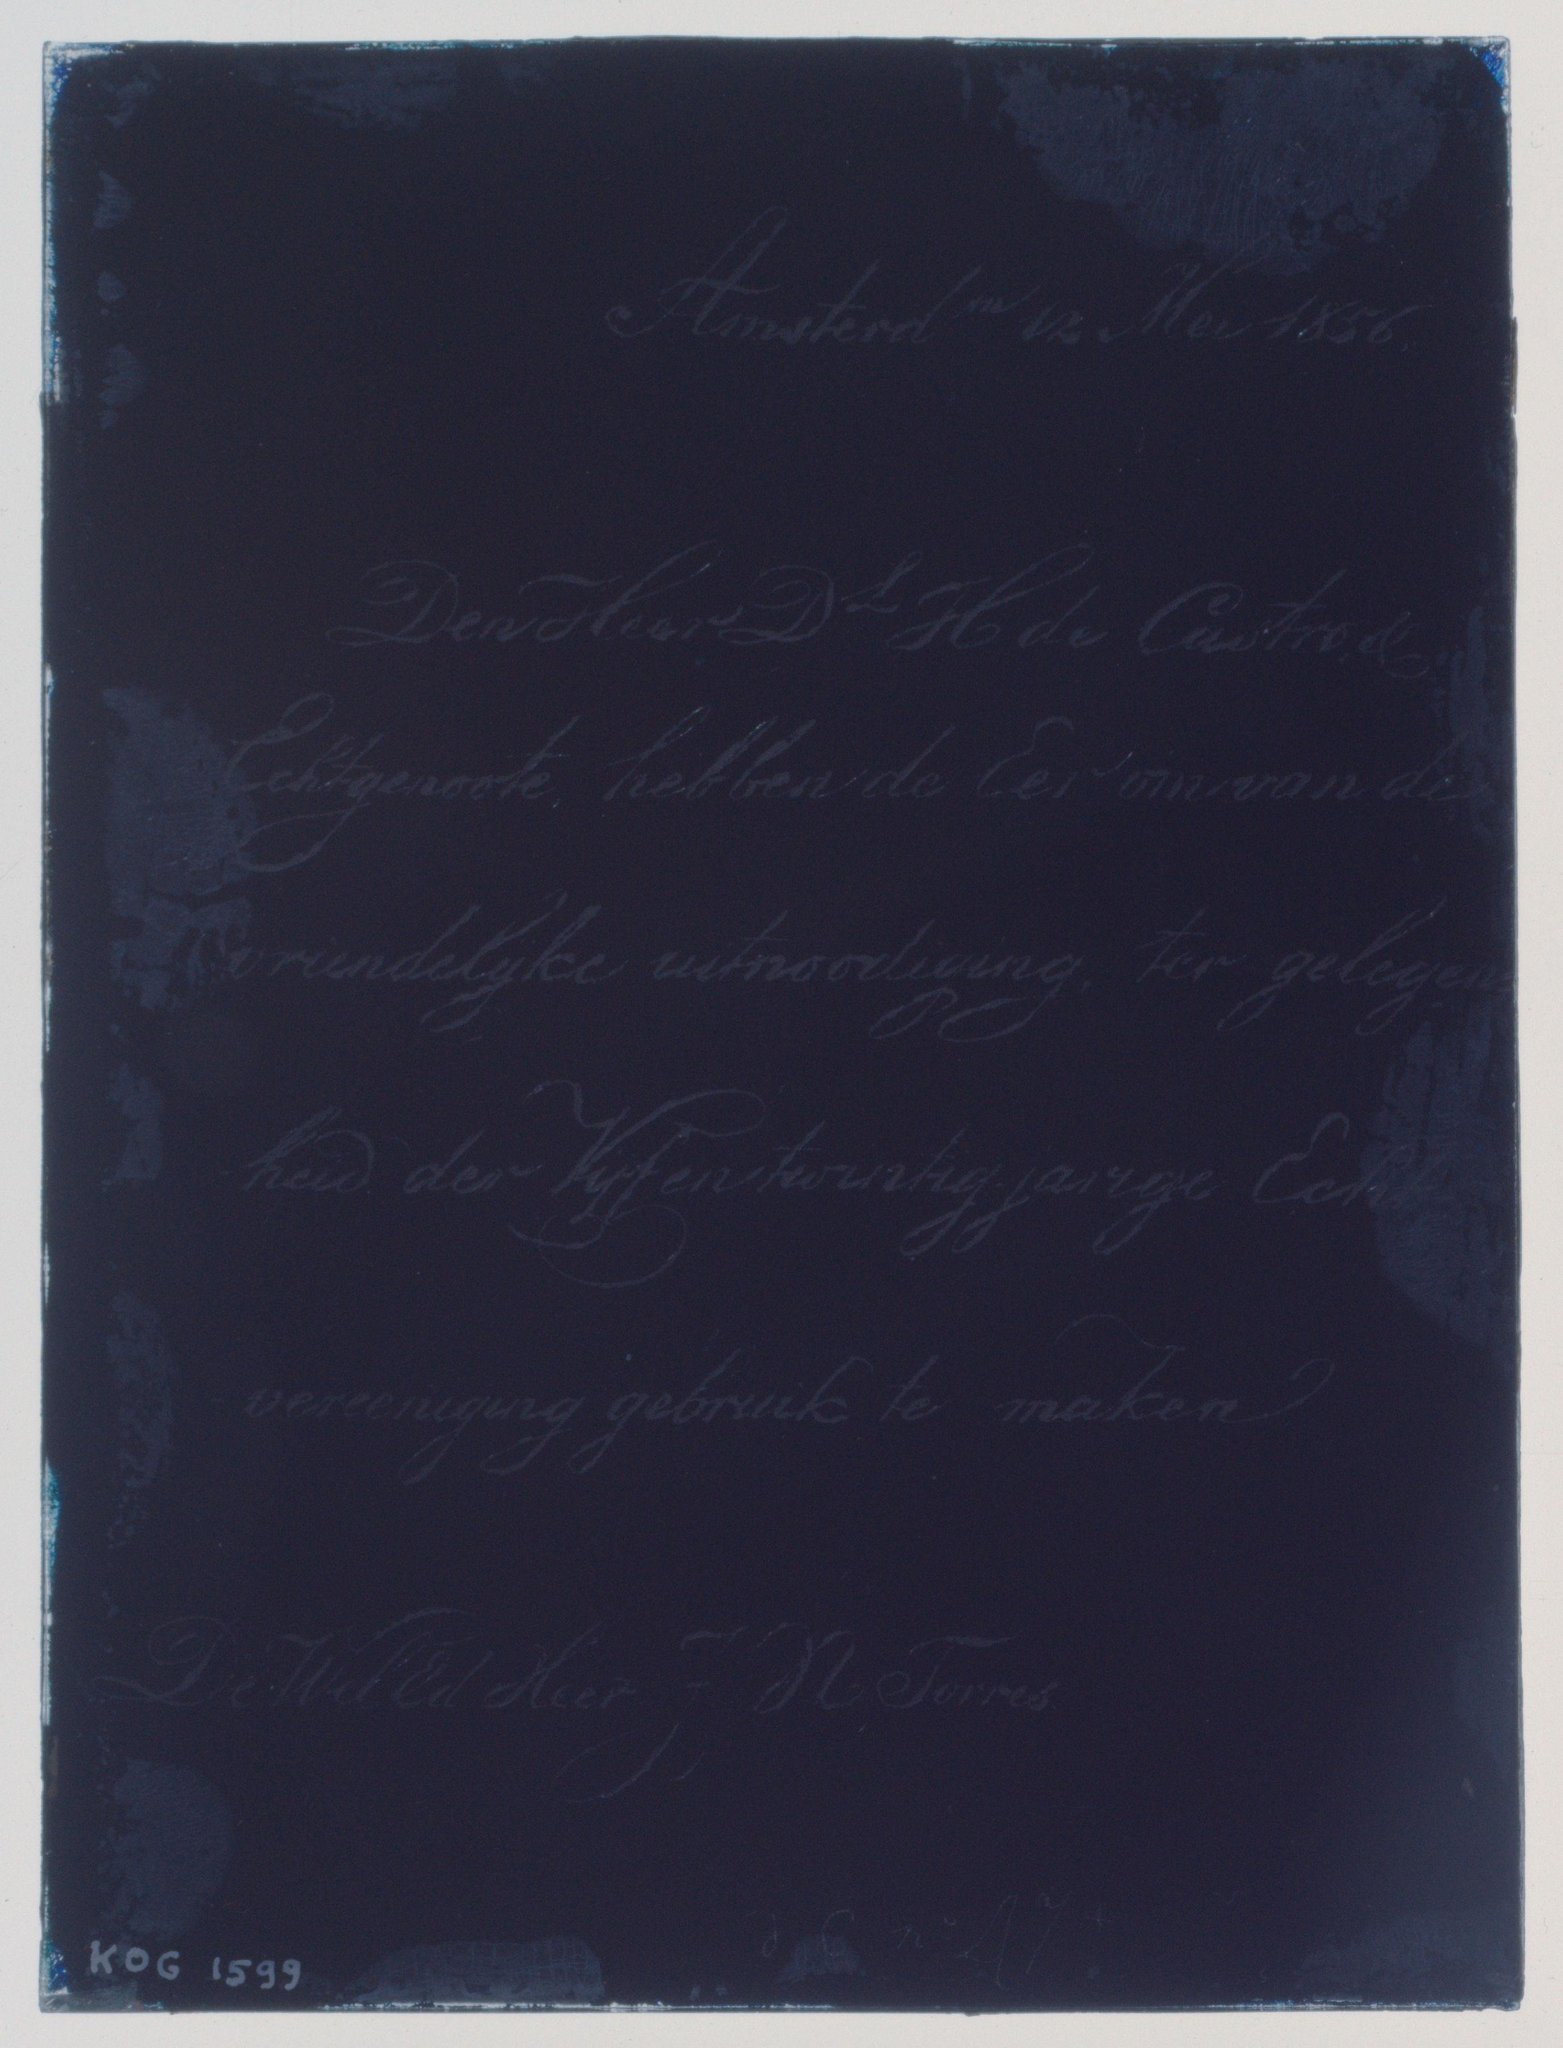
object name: light window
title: Ruit met het opschrift: De Heer D.H.de Castro & Echtgenoote hebben de Eer ... gebruik te maken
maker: daniël henriques de castro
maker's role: glasgraveur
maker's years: 1806-1863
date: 1856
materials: glass, oil, paper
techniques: diamond point engraving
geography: amsterdam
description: Rechthoekige ruit aan de achterzijde beschilderd met zwarte verf waar over blauw papier is beplakt. Op het ruitje is gegraveerd: Amsterdam 12 mei 1856/ De Heer D.H.de Castro &/ Echtgenoote hebben de Eer om van de/ vriendelijke uitnoodiging, ter gelegen/ heid der Vijf-en-twintigjarge Echt-/ vereeniging gebruik te maken./ De WelEd.Heer J.N.Torres